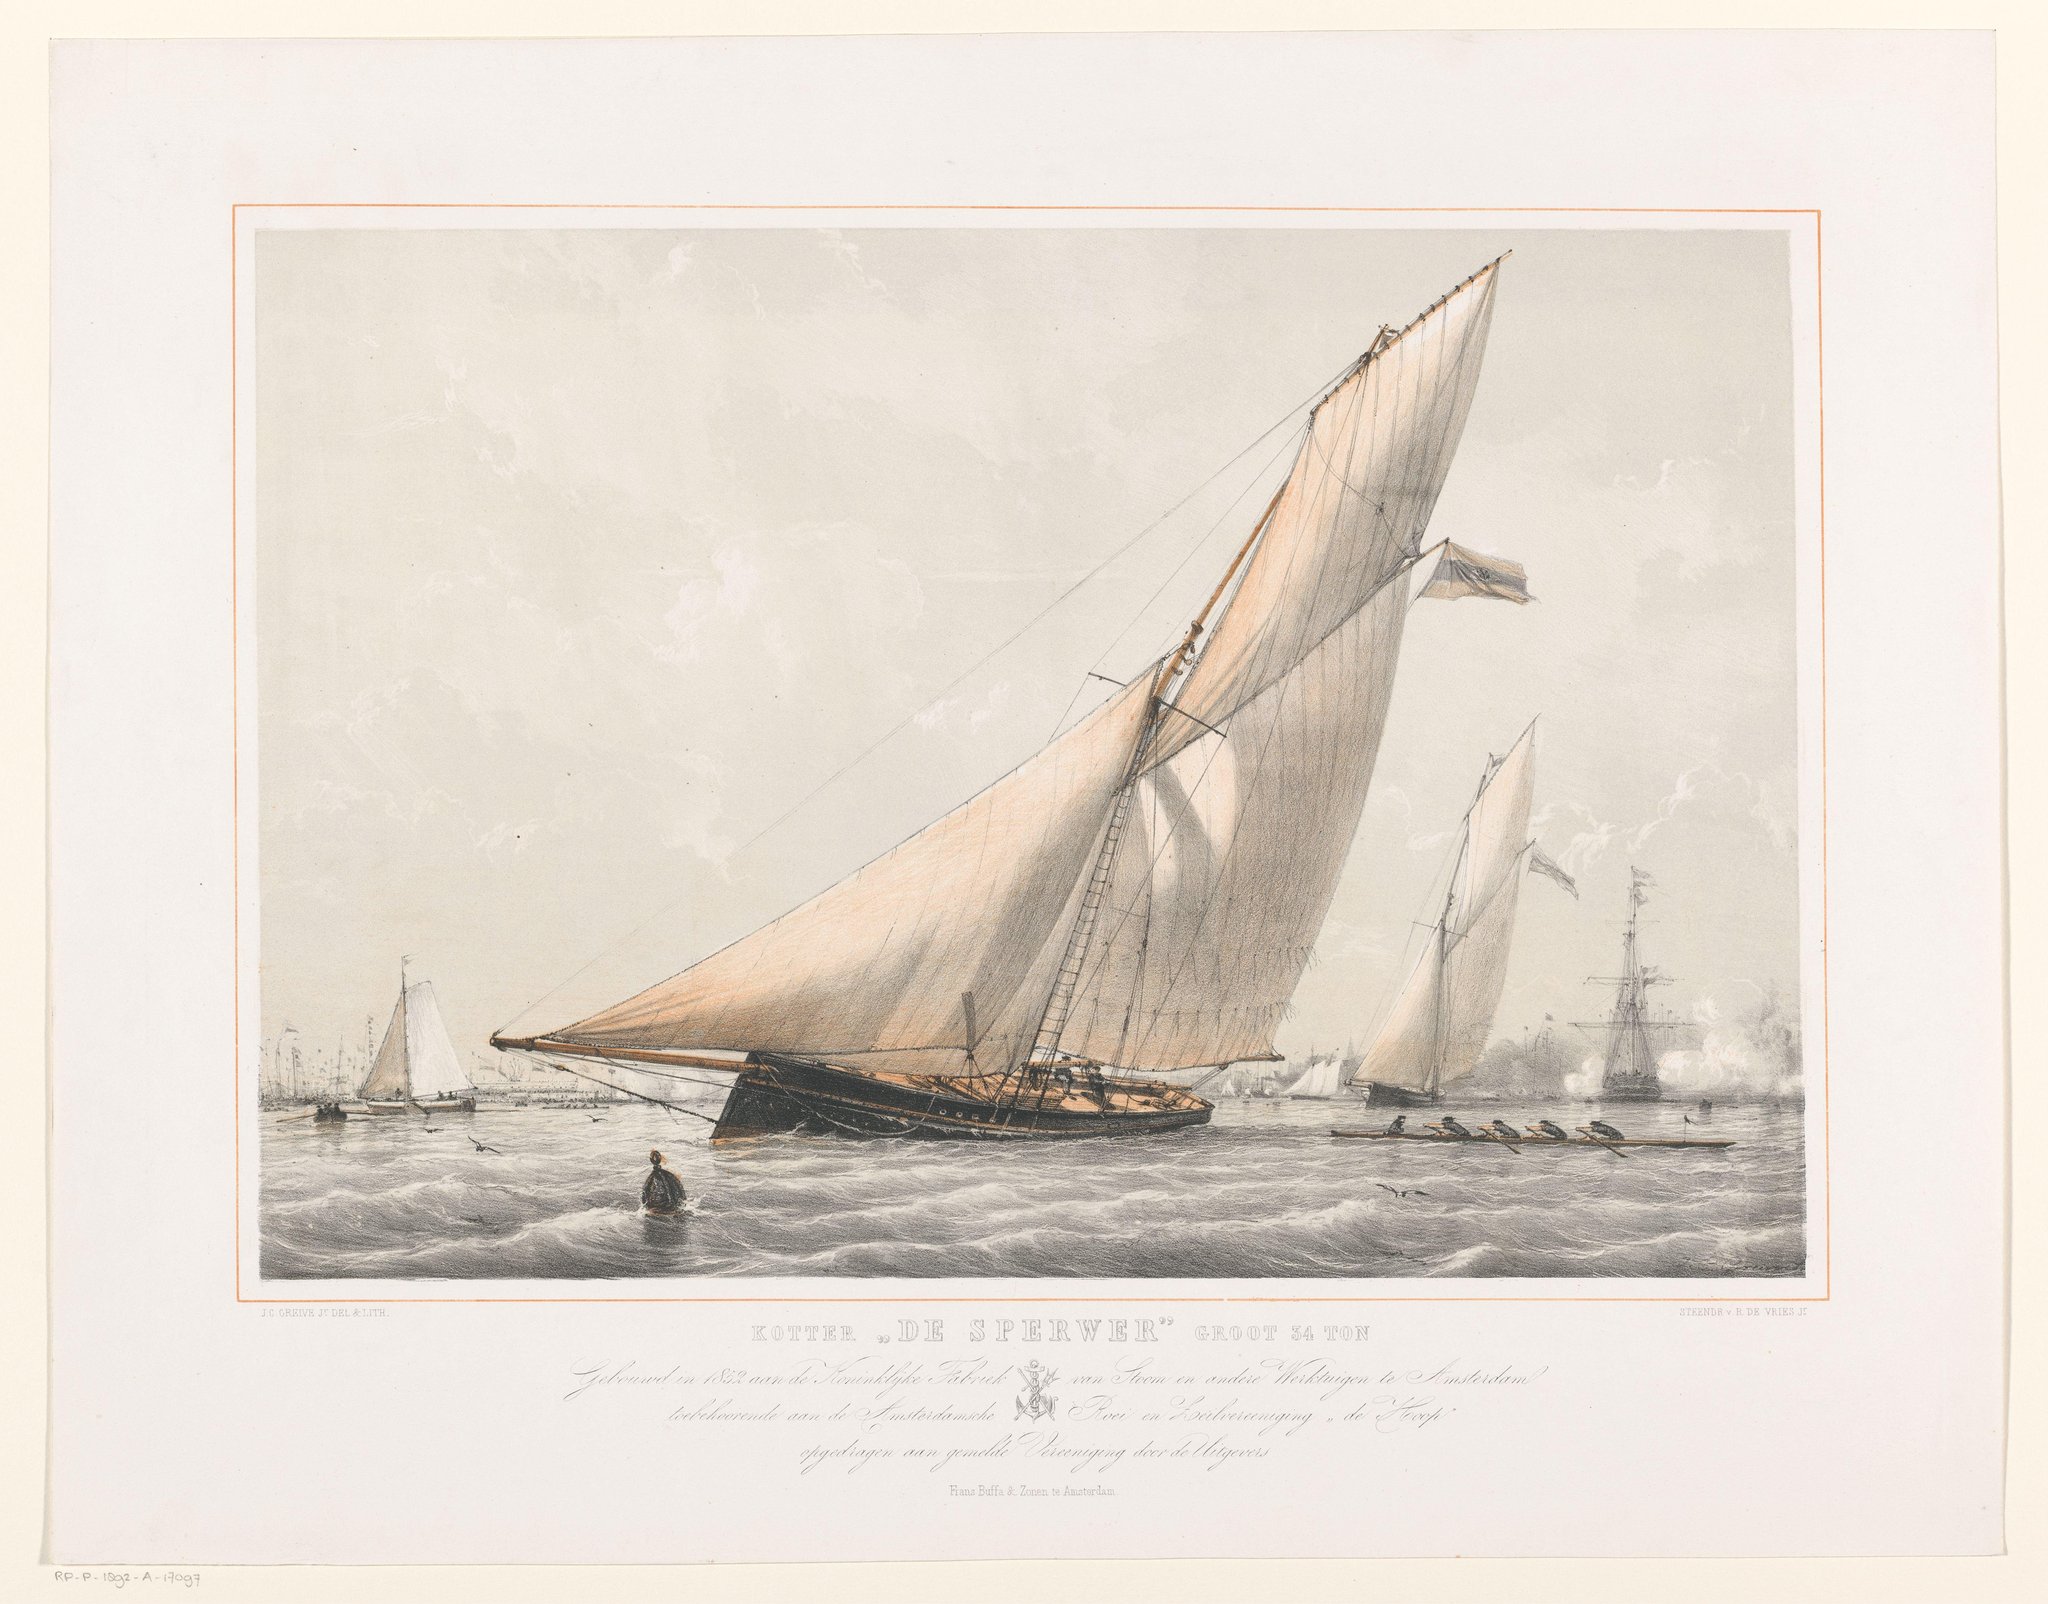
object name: print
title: Kotter "De Sperwer"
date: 1852-1874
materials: paper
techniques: tone lithography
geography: amsterdam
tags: ships (in general)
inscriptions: collector's mark: Lugt 2228, caption: ‘KOTTER "DE SPERWER" GROOT 34 TON// Gebouwd in 1852 aan de Koninklijke Fabriek van Stoom en andere Werktuigen te Amsterdam// toebehoorende aan de Amsterdamsche Roei en Zeilvereniging "de Hoop"// opgedragen aan de gemelde Wereeniging door de Uitgevers’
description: Zeilkotter Sperwer (gebouwd in 1852) varend op het IJ(?). Daarnaast vijf figuren in een roeiboot. In de achtergrond zeilboten en -schepen in een haven.